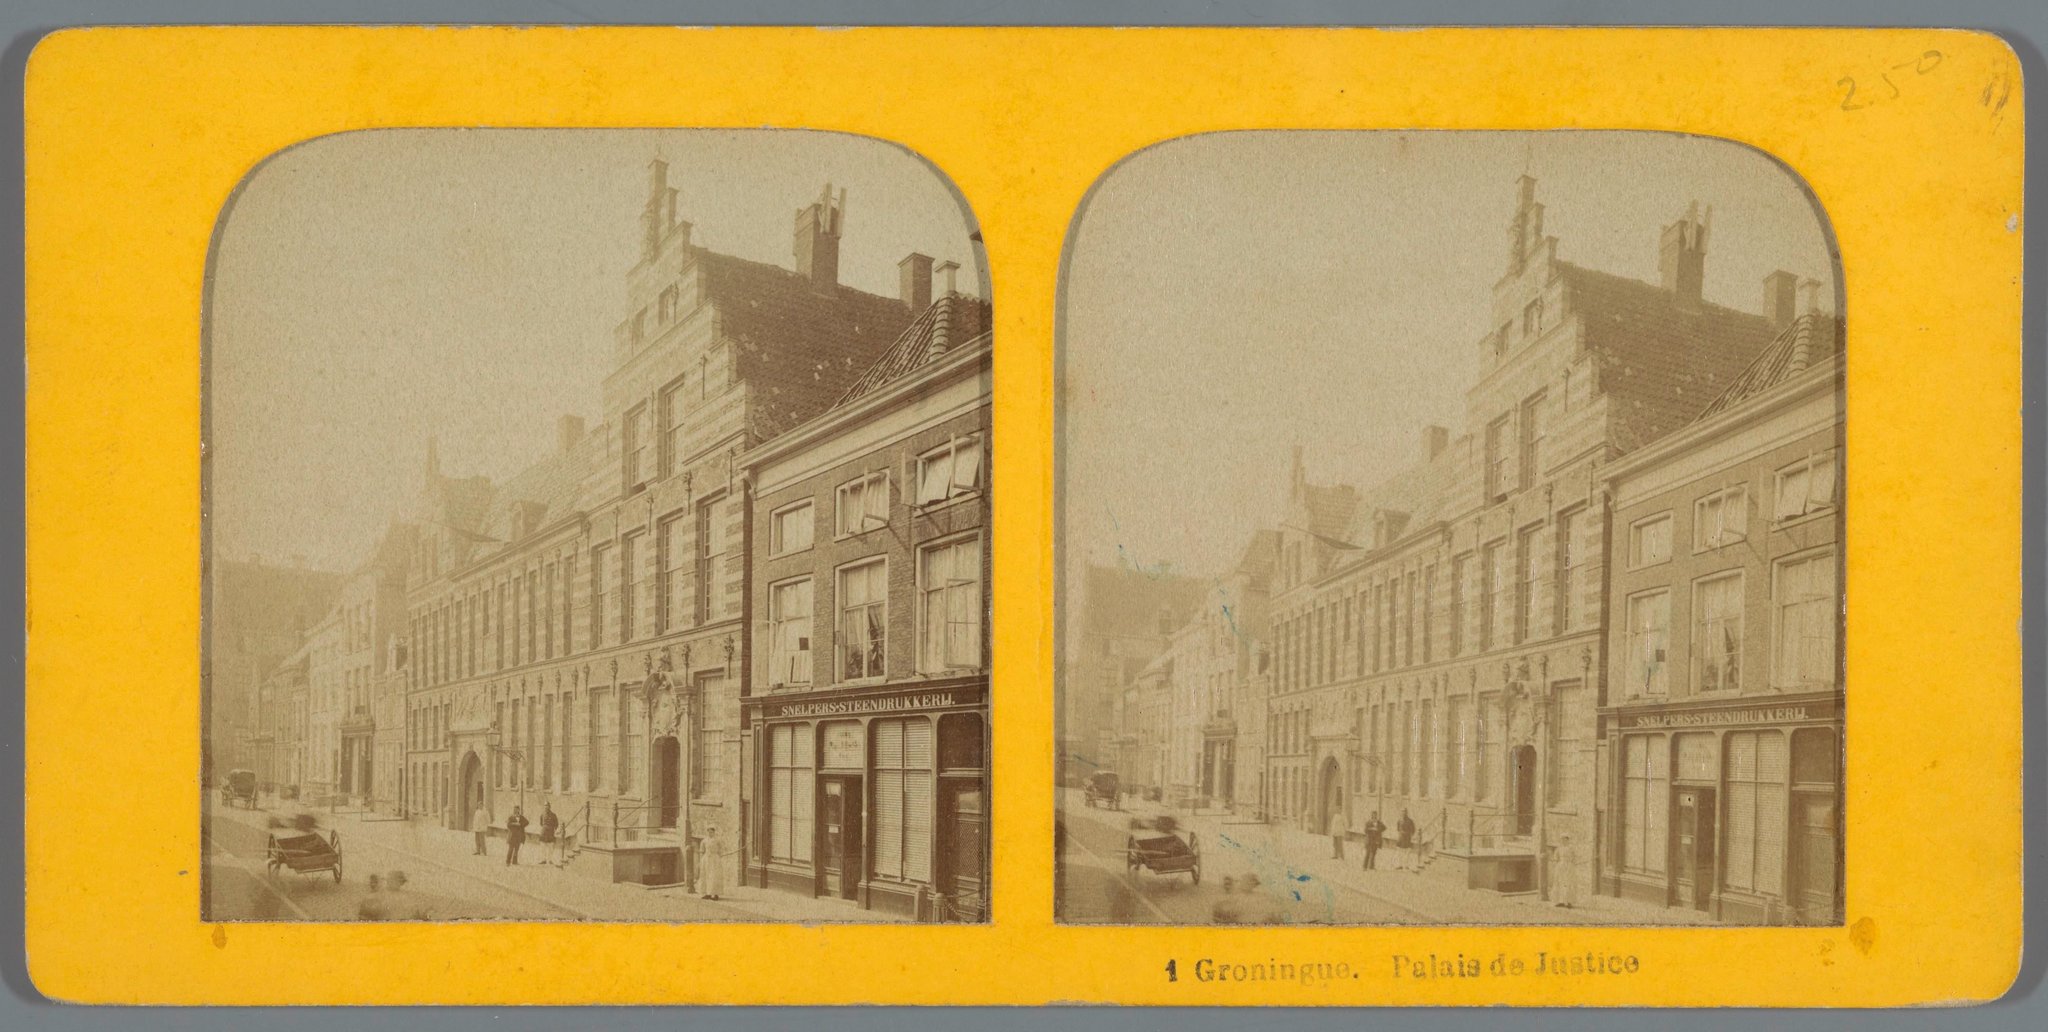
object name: tissue stereograph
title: Groningue. Palais de Justice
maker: Anonymous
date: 1855-1875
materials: cardboard, paper, photographic support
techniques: albumen print, cutting, hand coloring, perforating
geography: groningen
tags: court building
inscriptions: number: ‘8.’, number: ‘1’